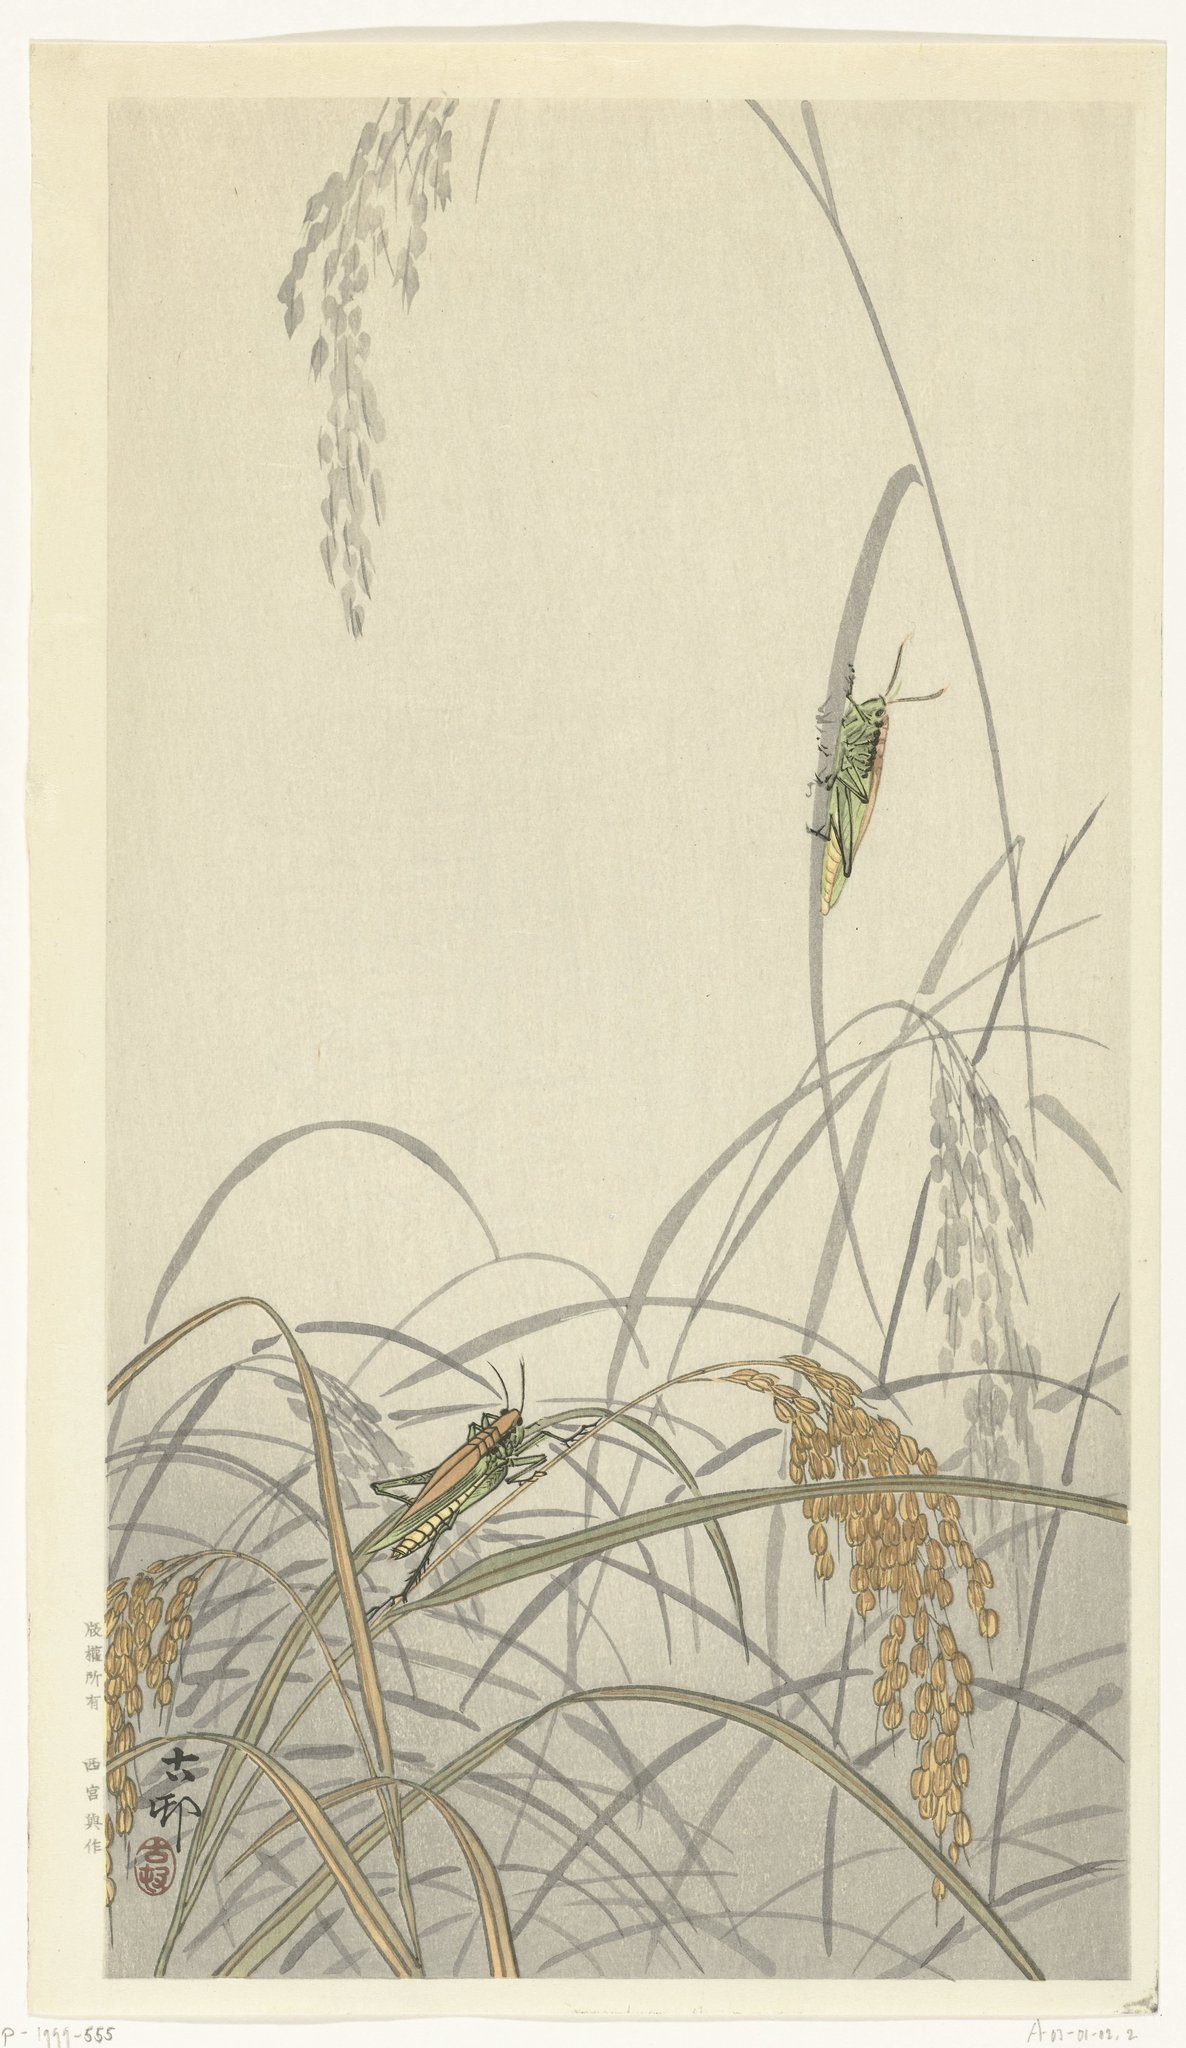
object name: print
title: Sprinkhanen op rijstplanten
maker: ohara koson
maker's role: print maker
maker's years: 1877-1945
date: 1900-1936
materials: paper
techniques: woodcut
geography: japan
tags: plants; vegetation, insects: grass-hopper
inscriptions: collector's mark: Lugt 2228